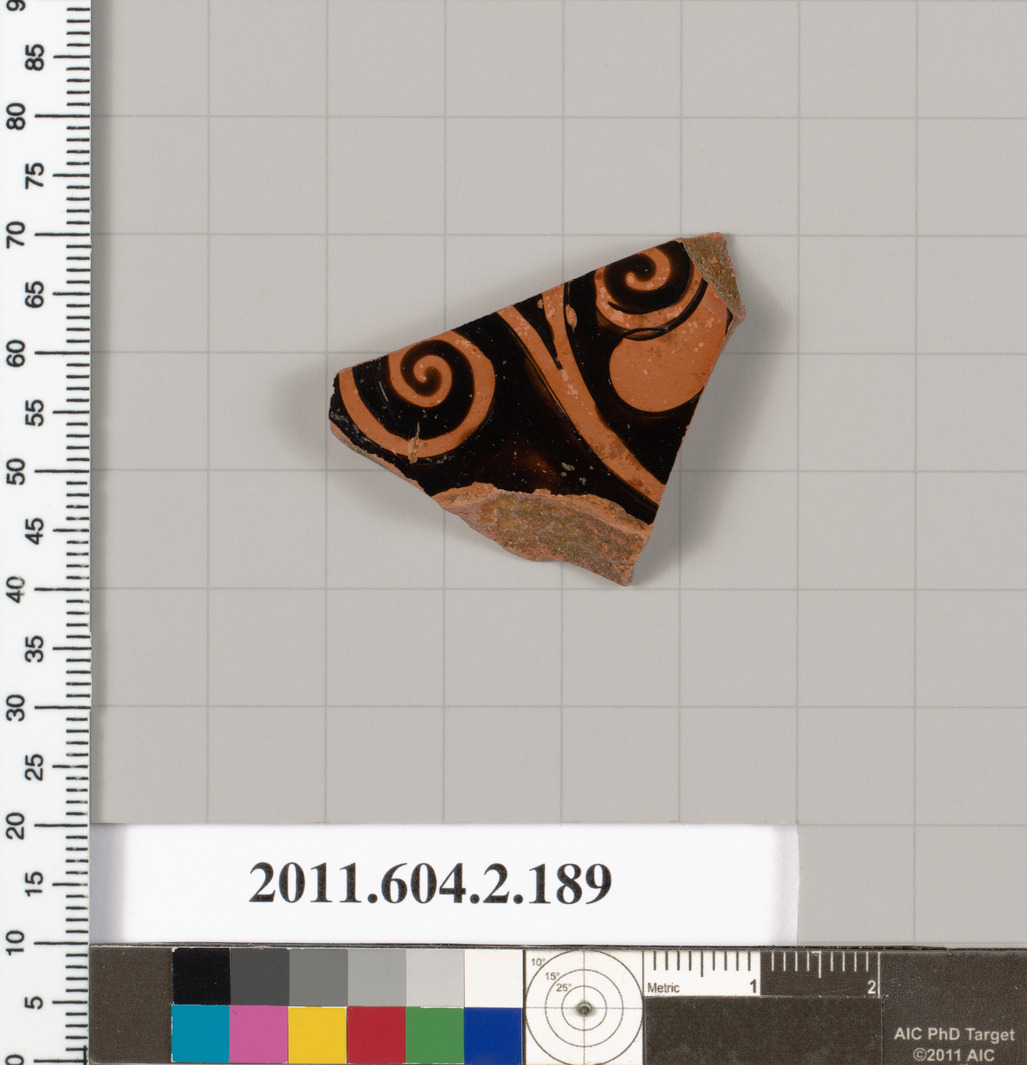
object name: stamnos fragment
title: Terracotta fragment of a stamnos (jar)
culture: greek, attic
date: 520-490 BCE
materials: terracotta